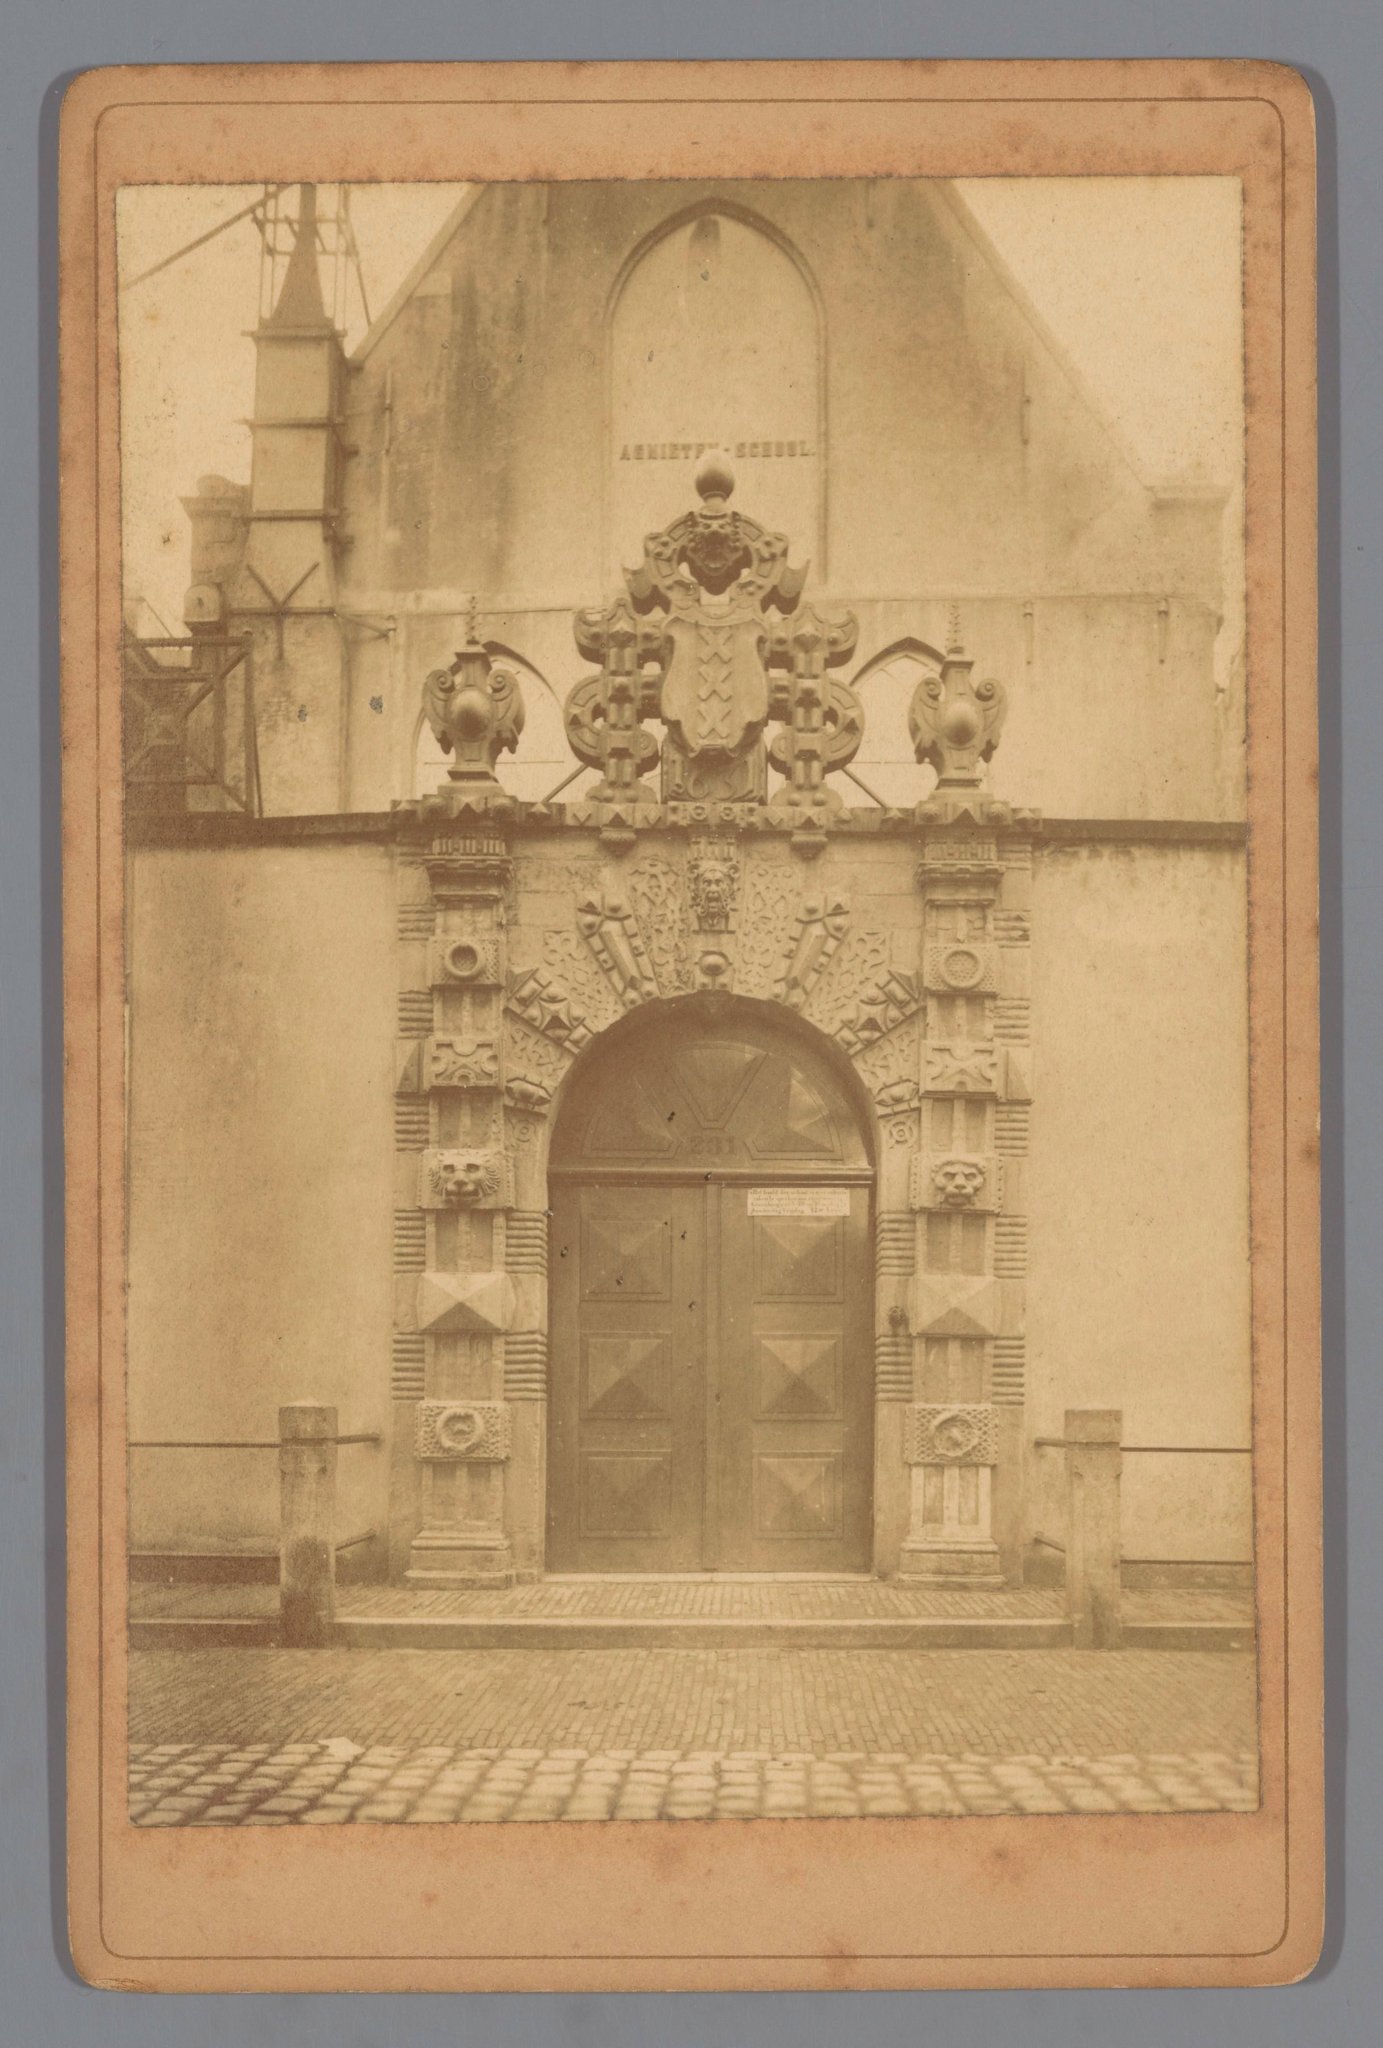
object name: cabinet photograph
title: Gezicht op de poort van de Agnietenschool in Amsterdam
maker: andreas theodorus rooswinkel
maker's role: fotograaf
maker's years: 1838-1909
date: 1868-1875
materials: cardboard, photographic support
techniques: albumen print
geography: amsterdam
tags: gate, entrance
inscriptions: retailer's mark: ‘GEBR. DOUWES./ ATELIER/ Grimburgwal 15/ AMSTERDAM.’